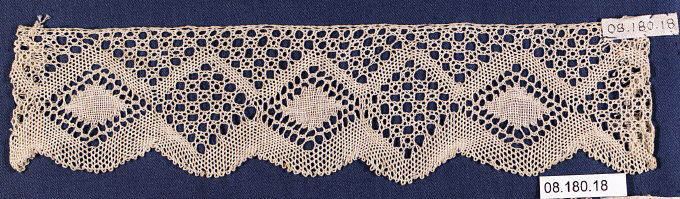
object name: torchon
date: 1801-1900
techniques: lace